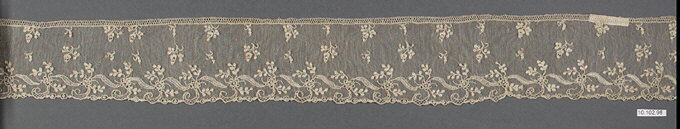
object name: alencon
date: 1701-1800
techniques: lace